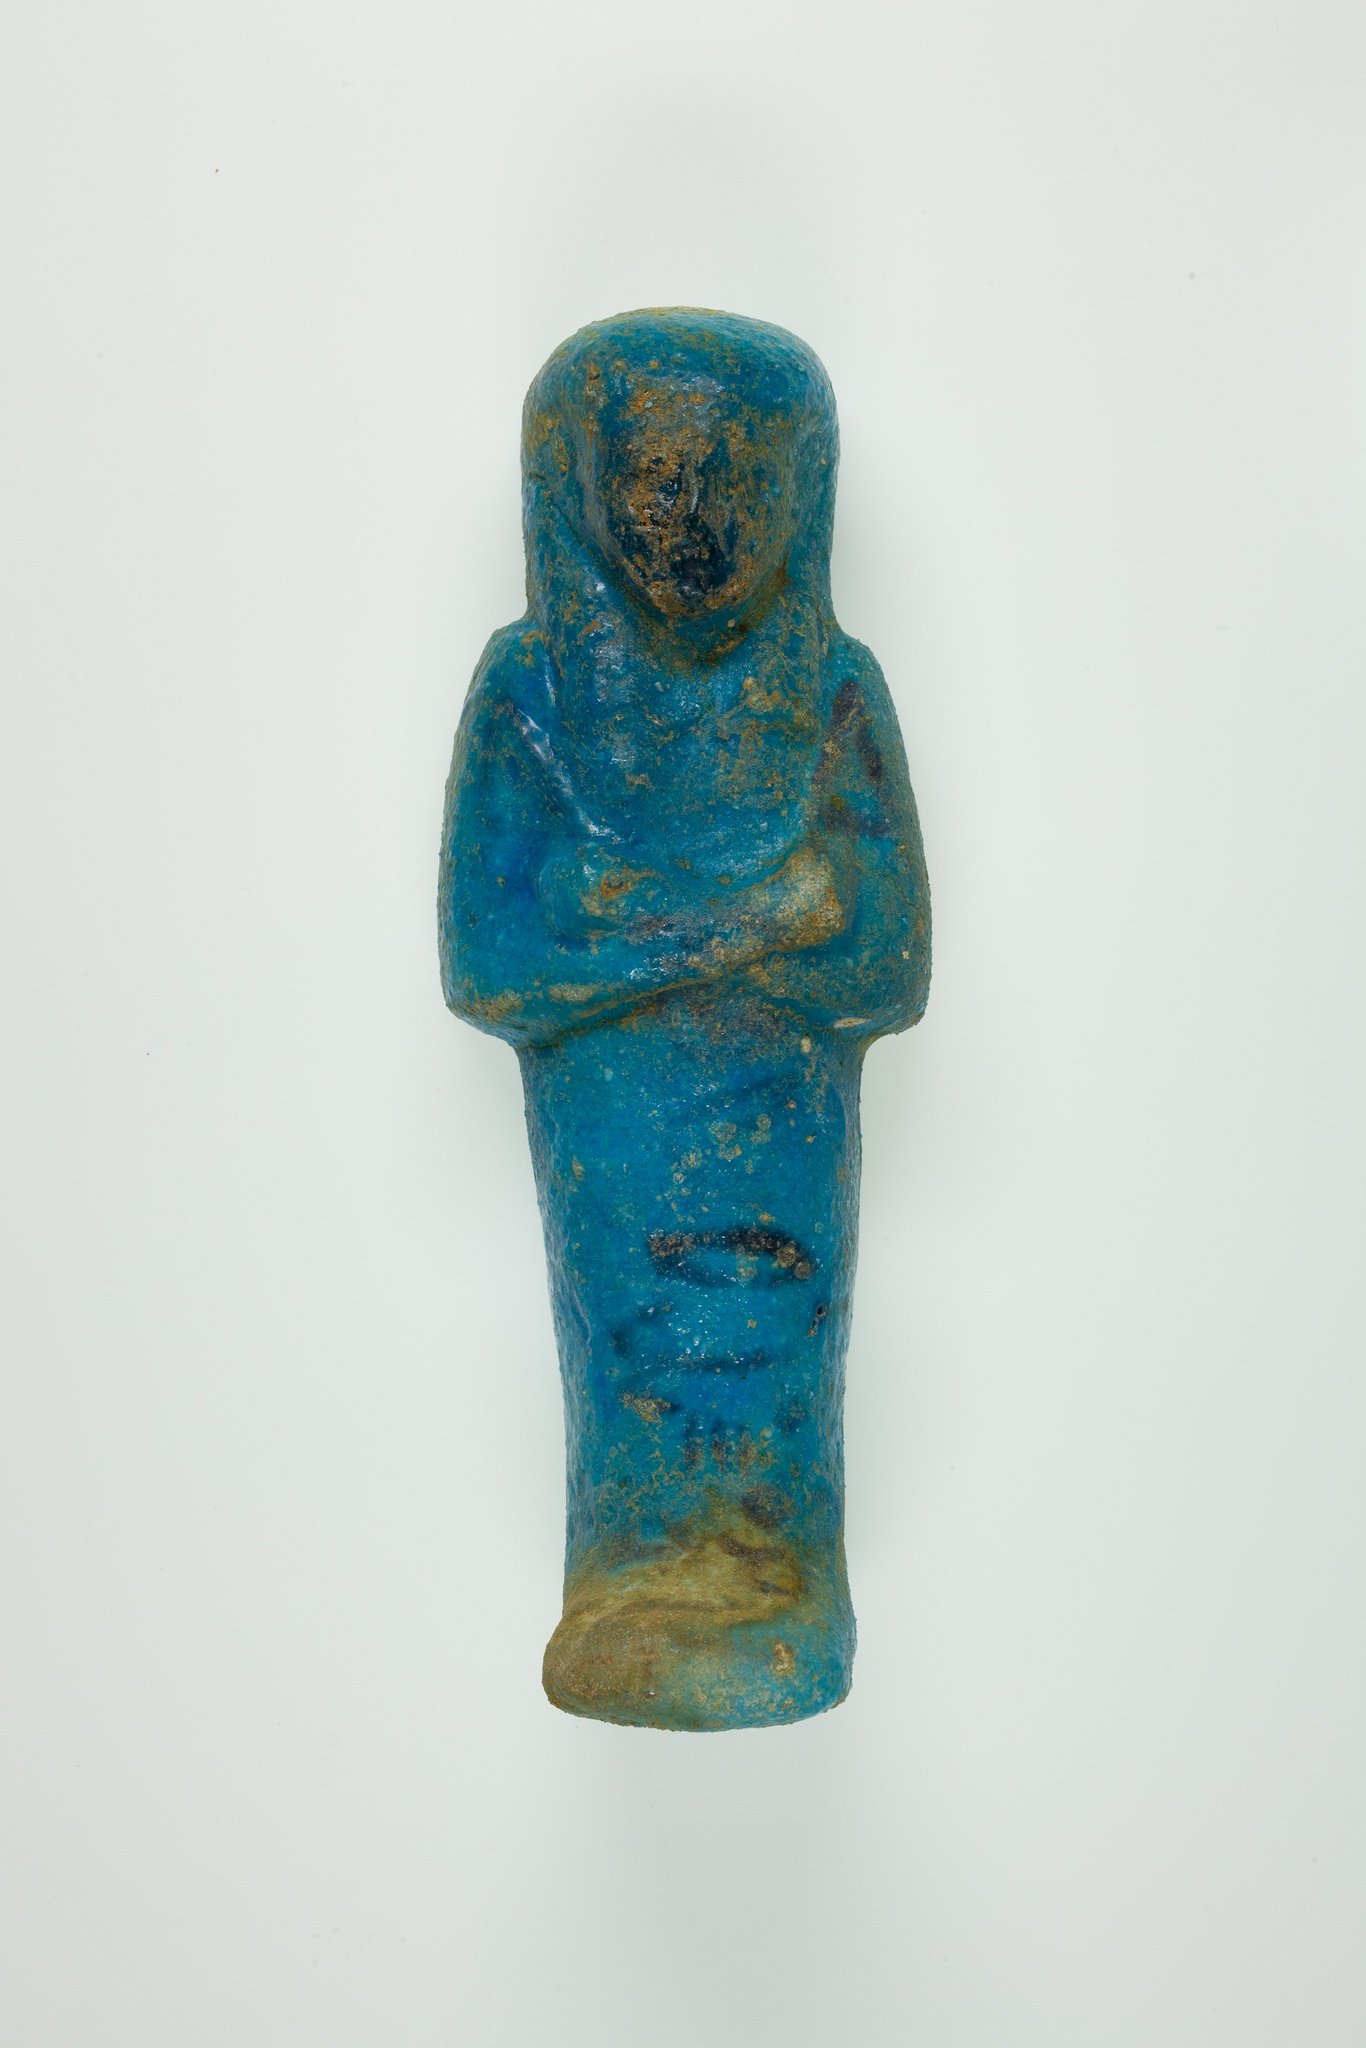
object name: worker shabti, henettawy c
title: Worker Shabti of Henettawy (C), Daughter of Isetemkheb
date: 990-970 BCE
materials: faience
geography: egypt